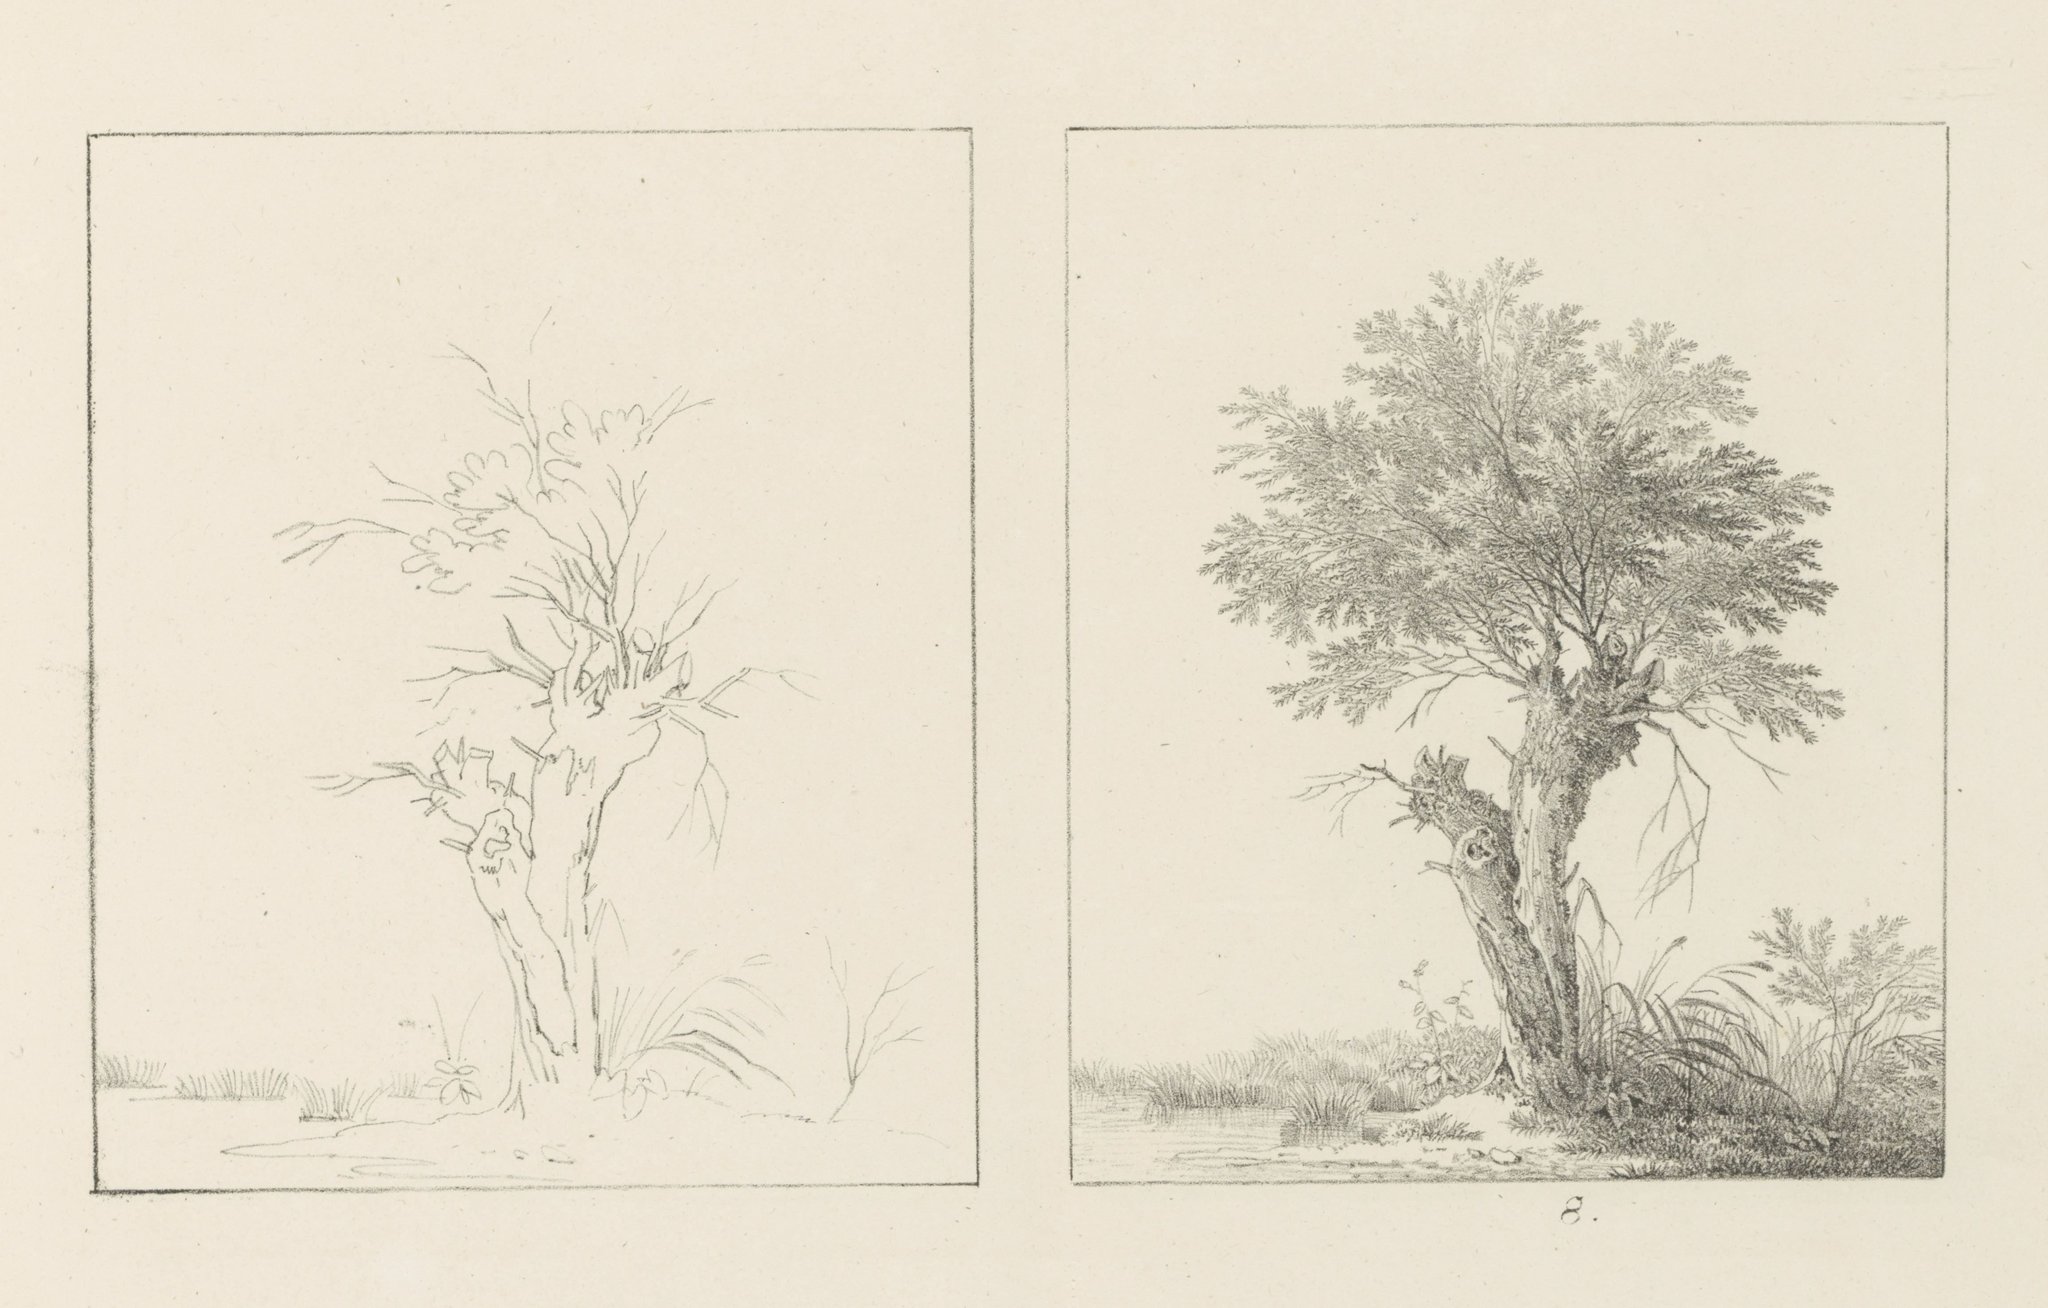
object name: print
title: Albumblad met twee voorstellingen van twee wilgen: links het ontwerp, rechts de uitvoering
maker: max josef wagenbauer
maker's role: print maker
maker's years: 1774-1829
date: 1816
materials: paper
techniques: lithograph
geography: munich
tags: trees, the graphic arts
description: Albumblad met twee voorstellingen van twee wilgen: links het ontwerp, rechts de uitvoering. Maakt deel uit van een album met 18 bladen met studies van bomen.